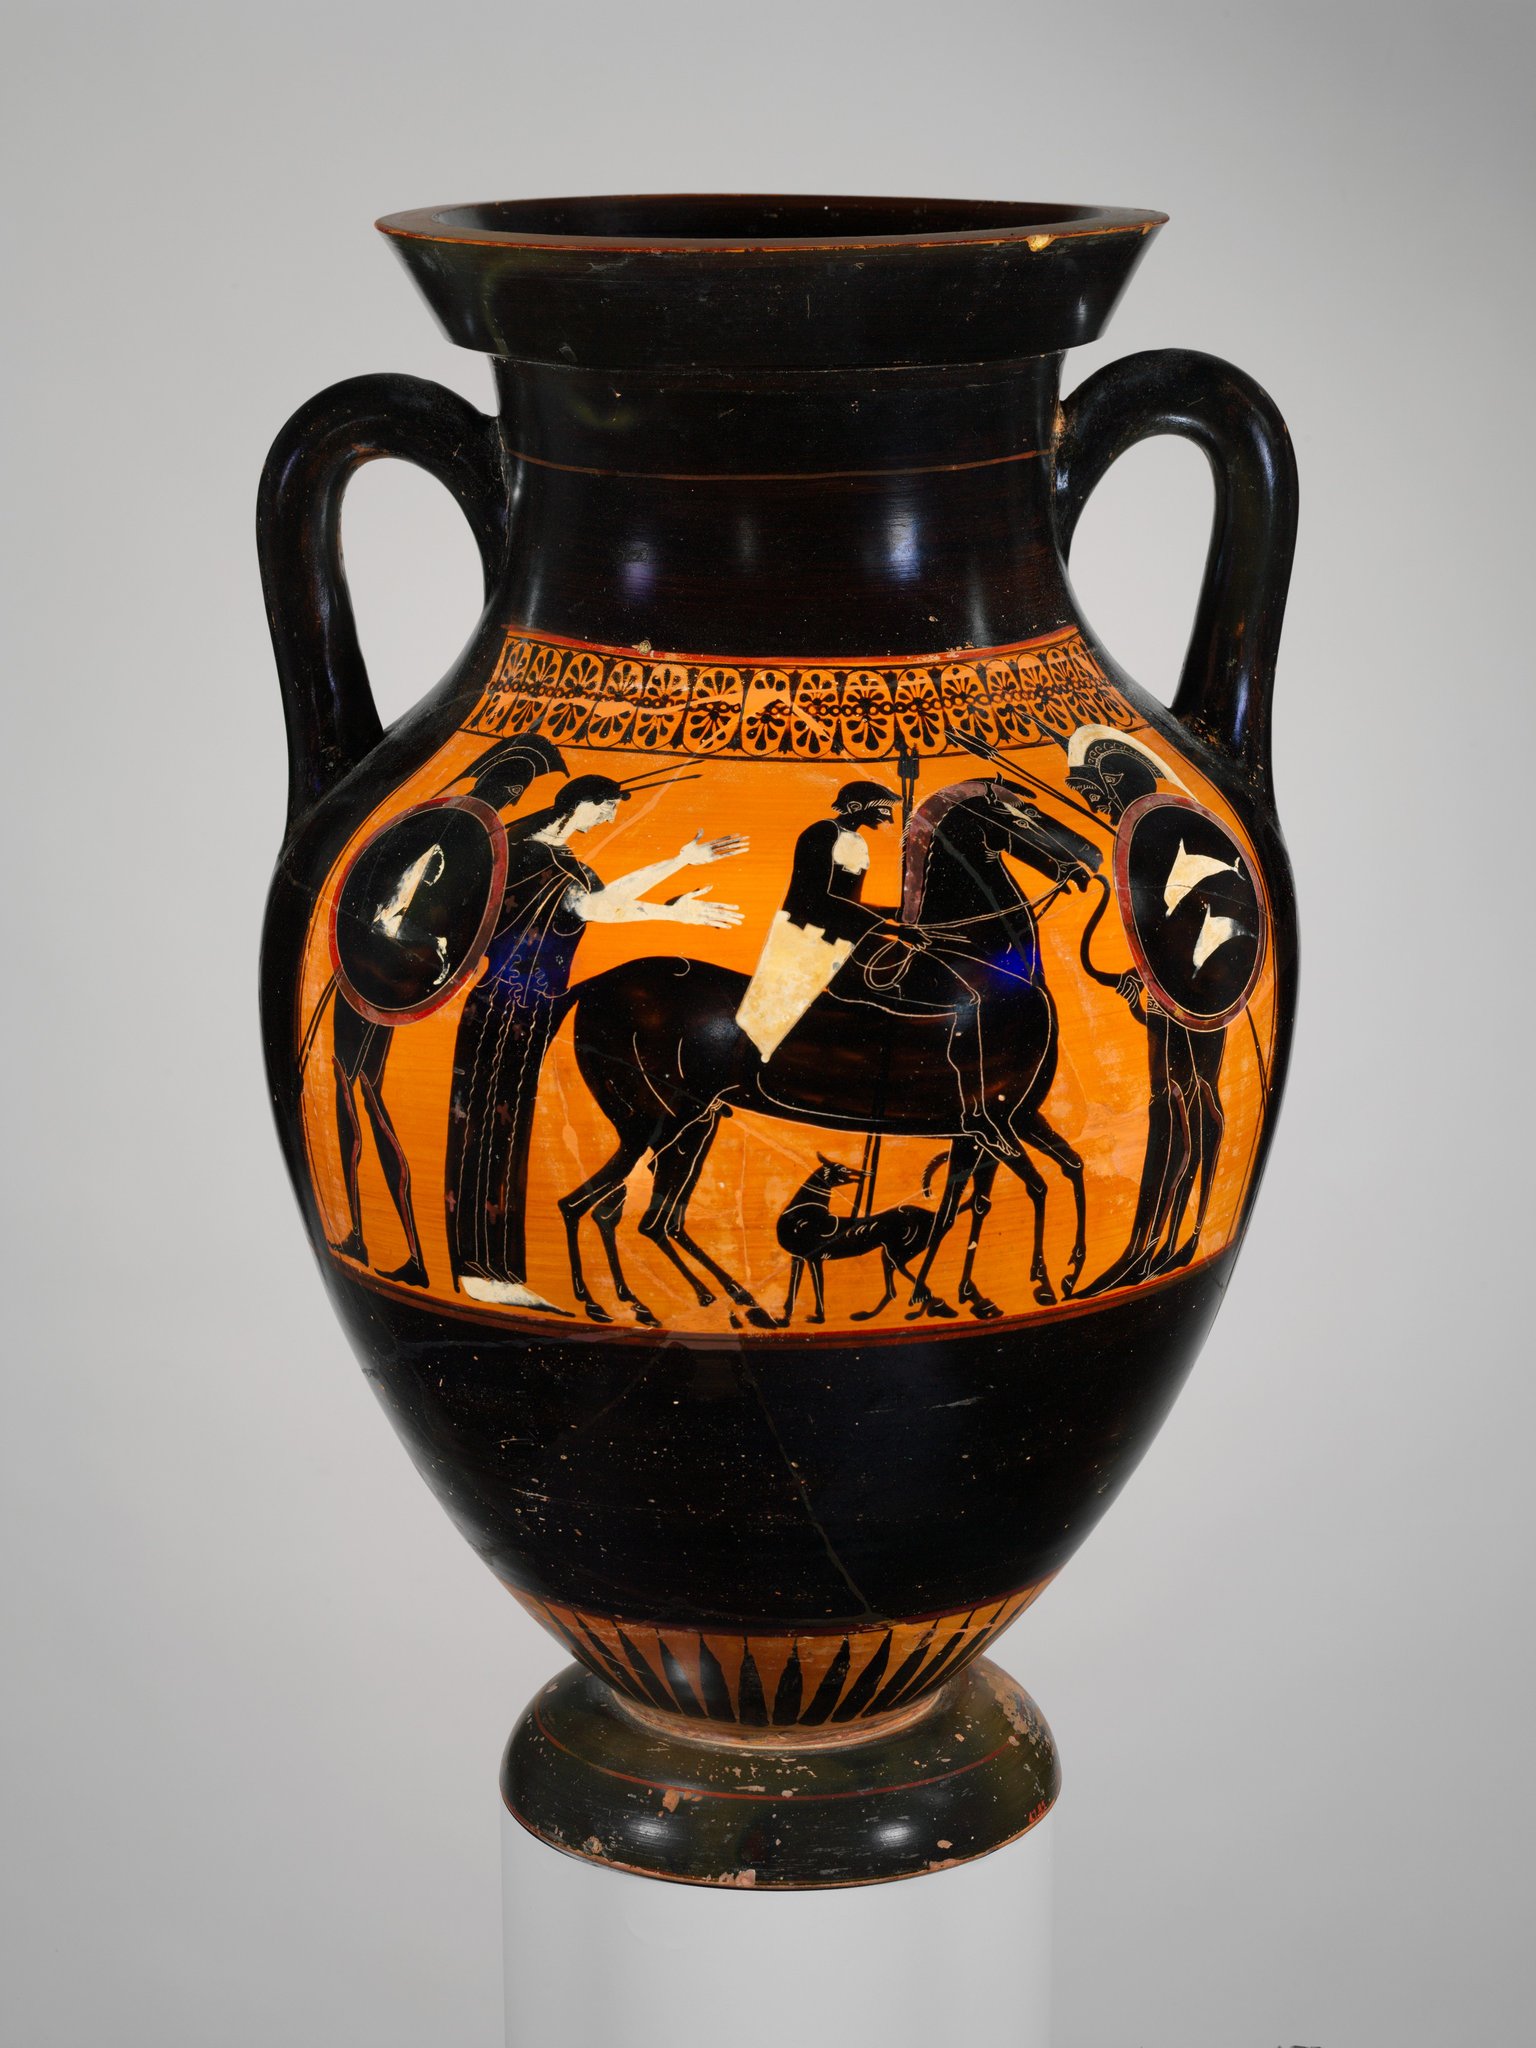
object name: amphora, type b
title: Terracotta amphora (jar)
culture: greek, attic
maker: group of toronto 305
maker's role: artist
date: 520 BCE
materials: terracotta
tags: shields,athena,hermes,dogs,horses,chariots,herakles